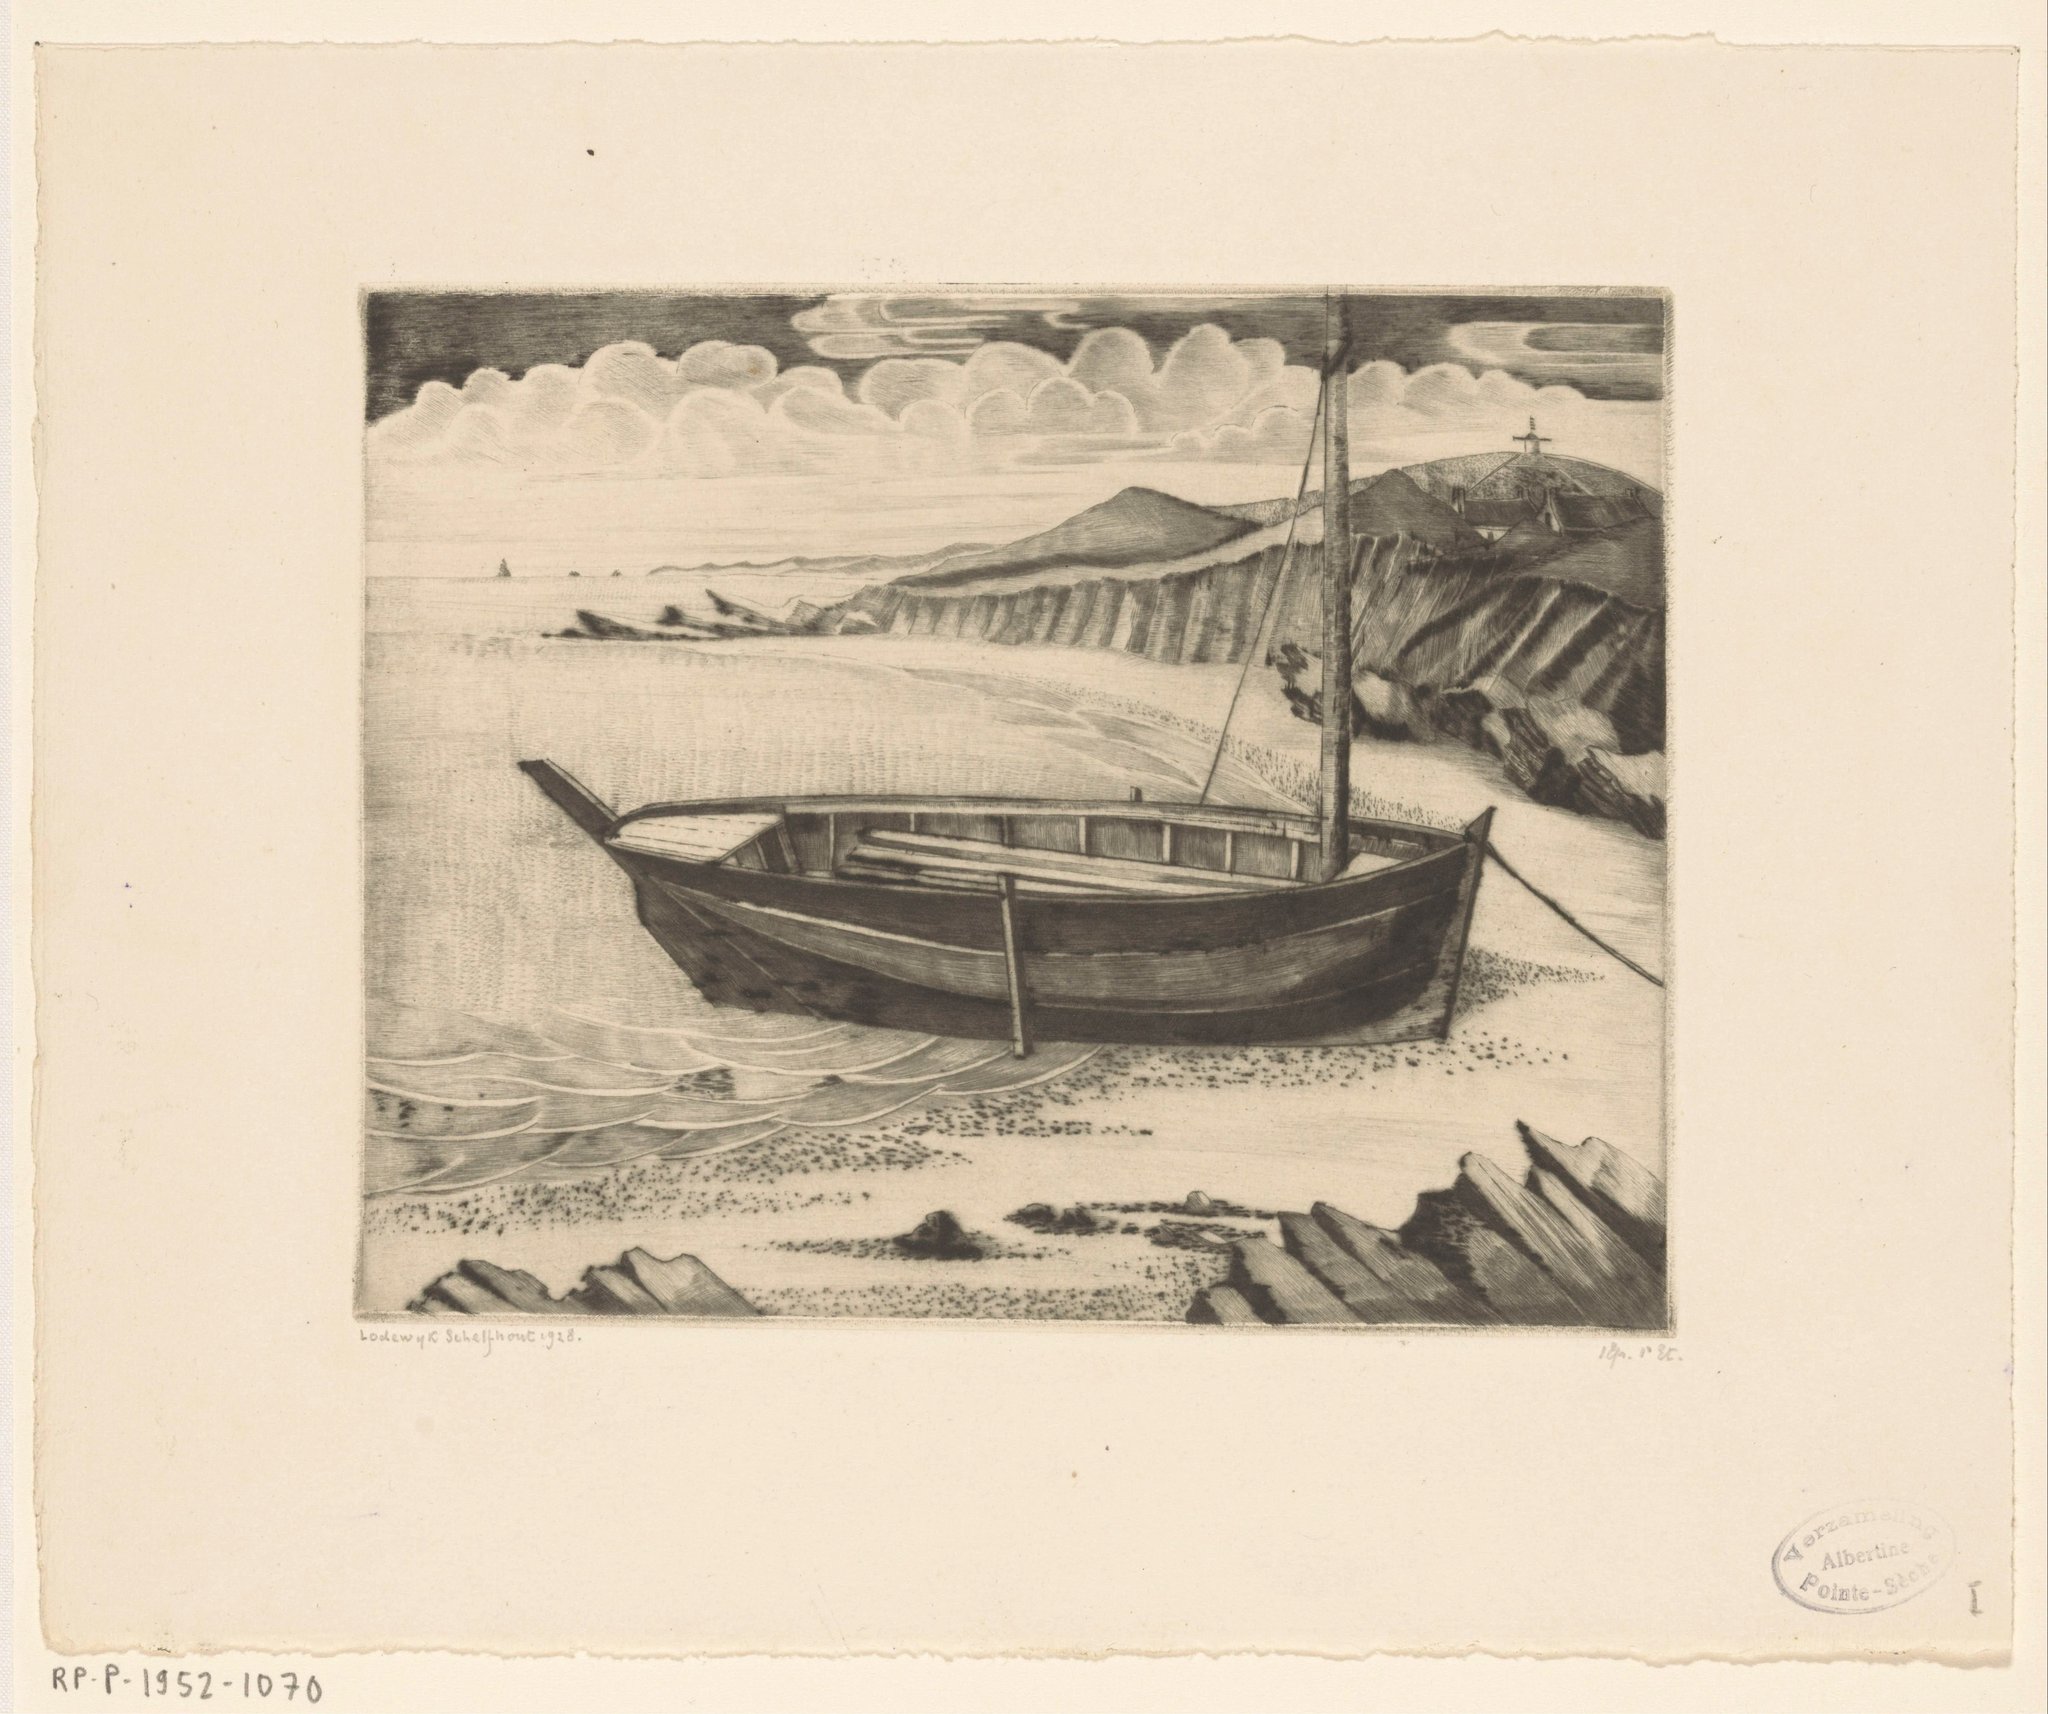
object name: print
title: Le Bateau Breton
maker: lodewijk schelfhout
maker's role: draughtsman, print maker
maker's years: 1881-1943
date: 1928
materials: paper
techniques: drypoint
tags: rocky coast, ships (in general), beach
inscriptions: collector's mark: Lugt 2228, collector's mark: Lugt 5i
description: Een afgemeerde boot op een strand in Bretagne.